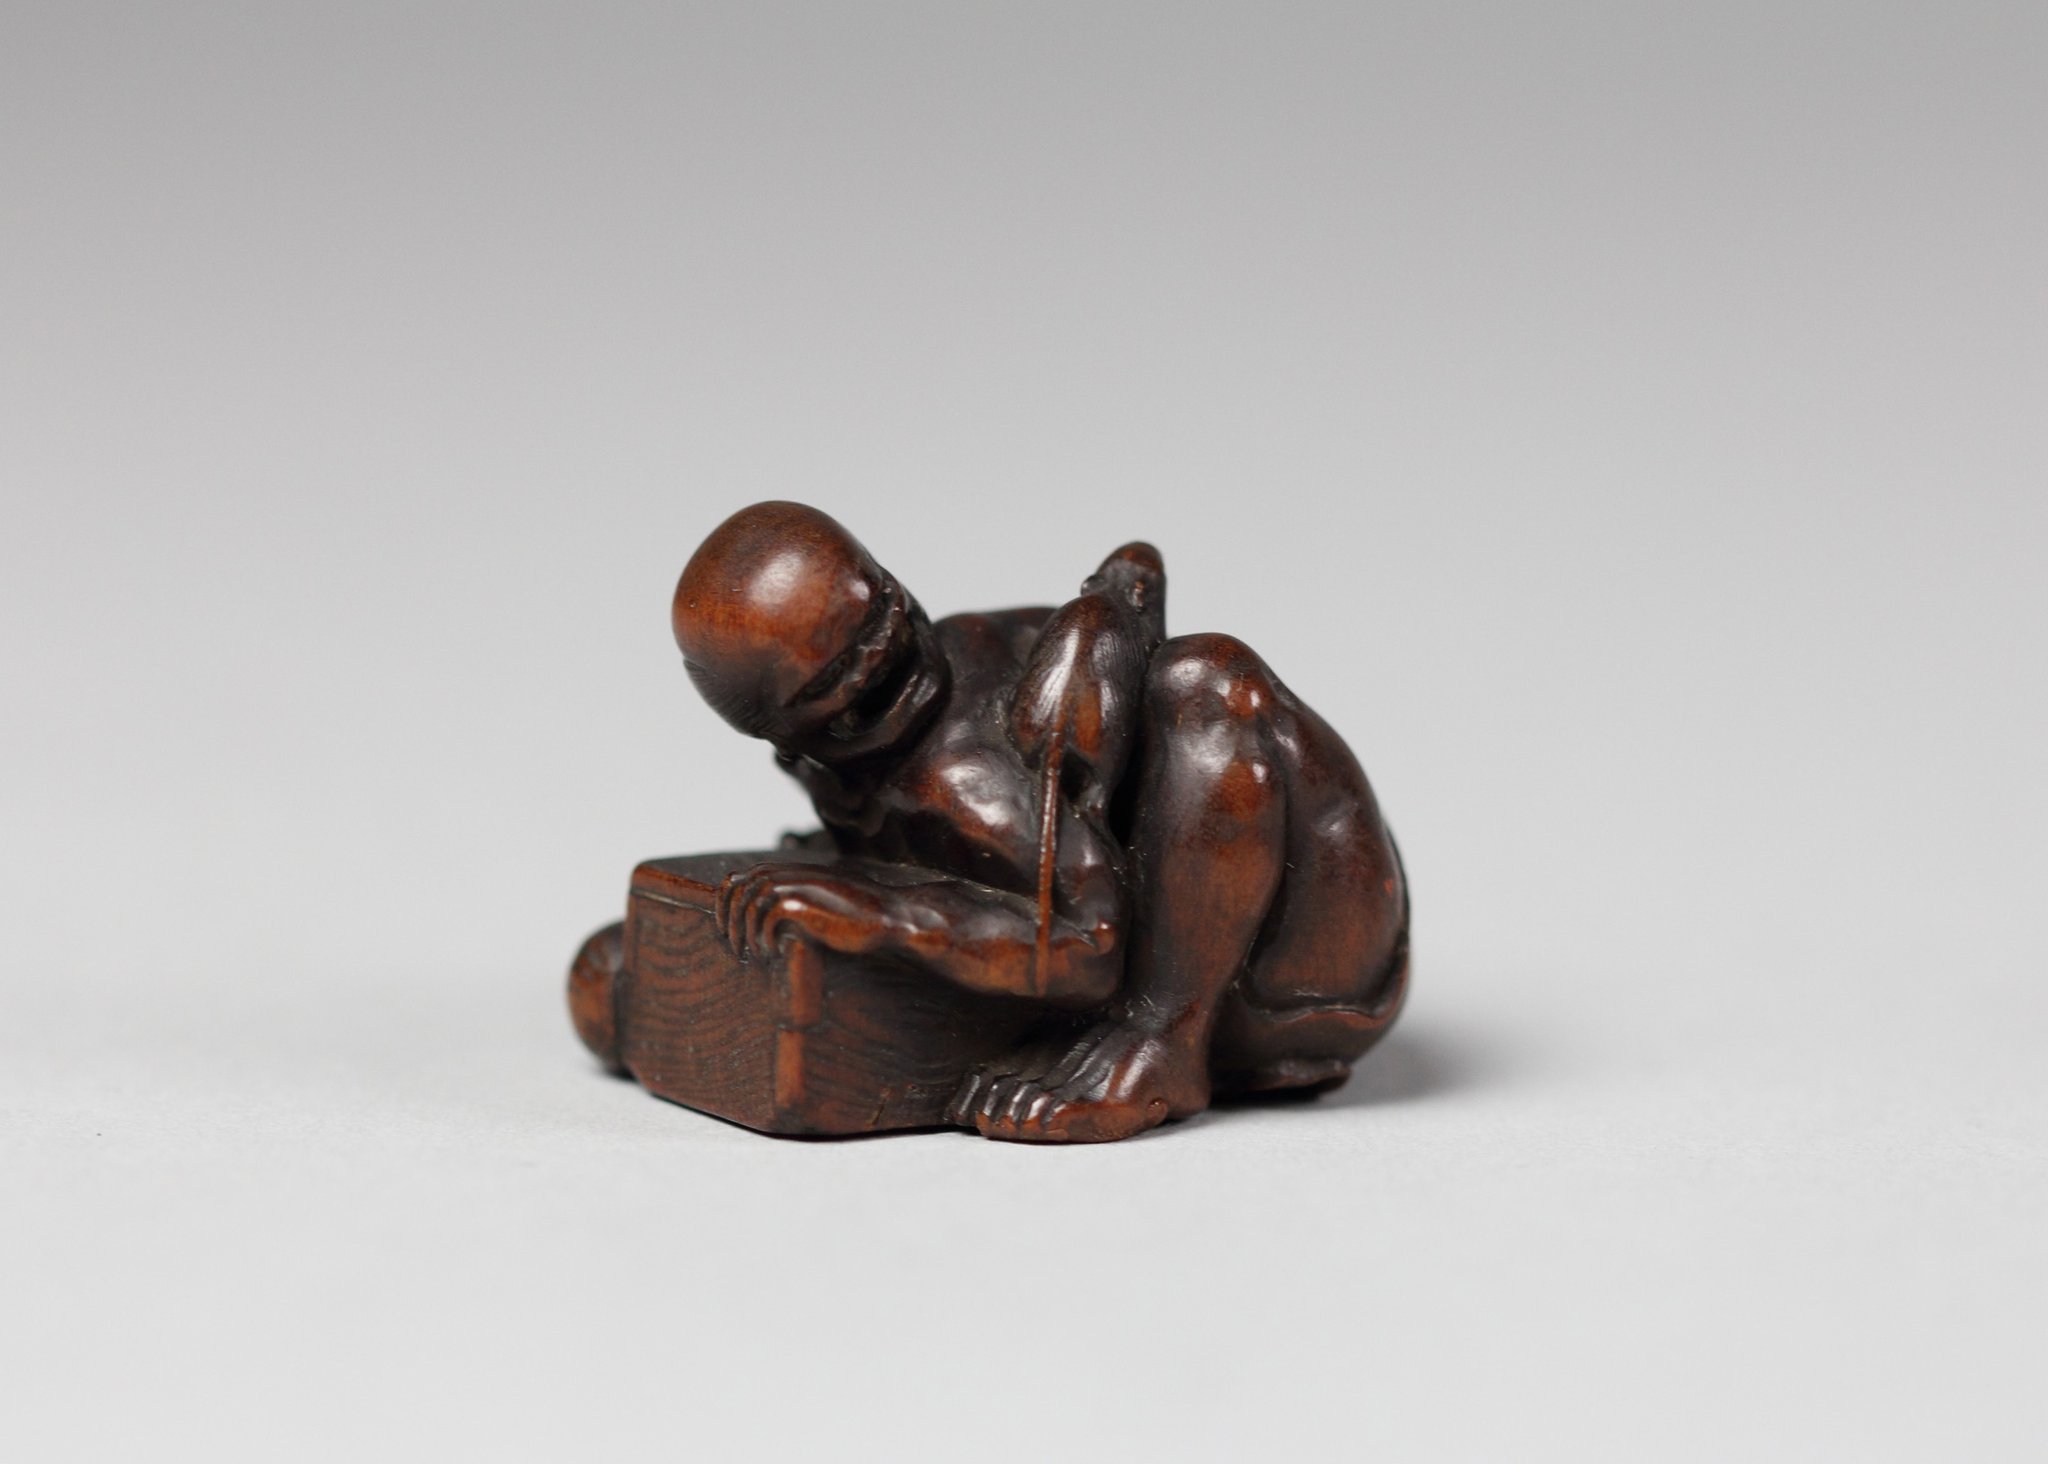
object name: netsuke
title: Netsuke of Man who Misses Catching a Rat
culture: japanese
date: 1801-1900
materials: wood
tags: animals,men